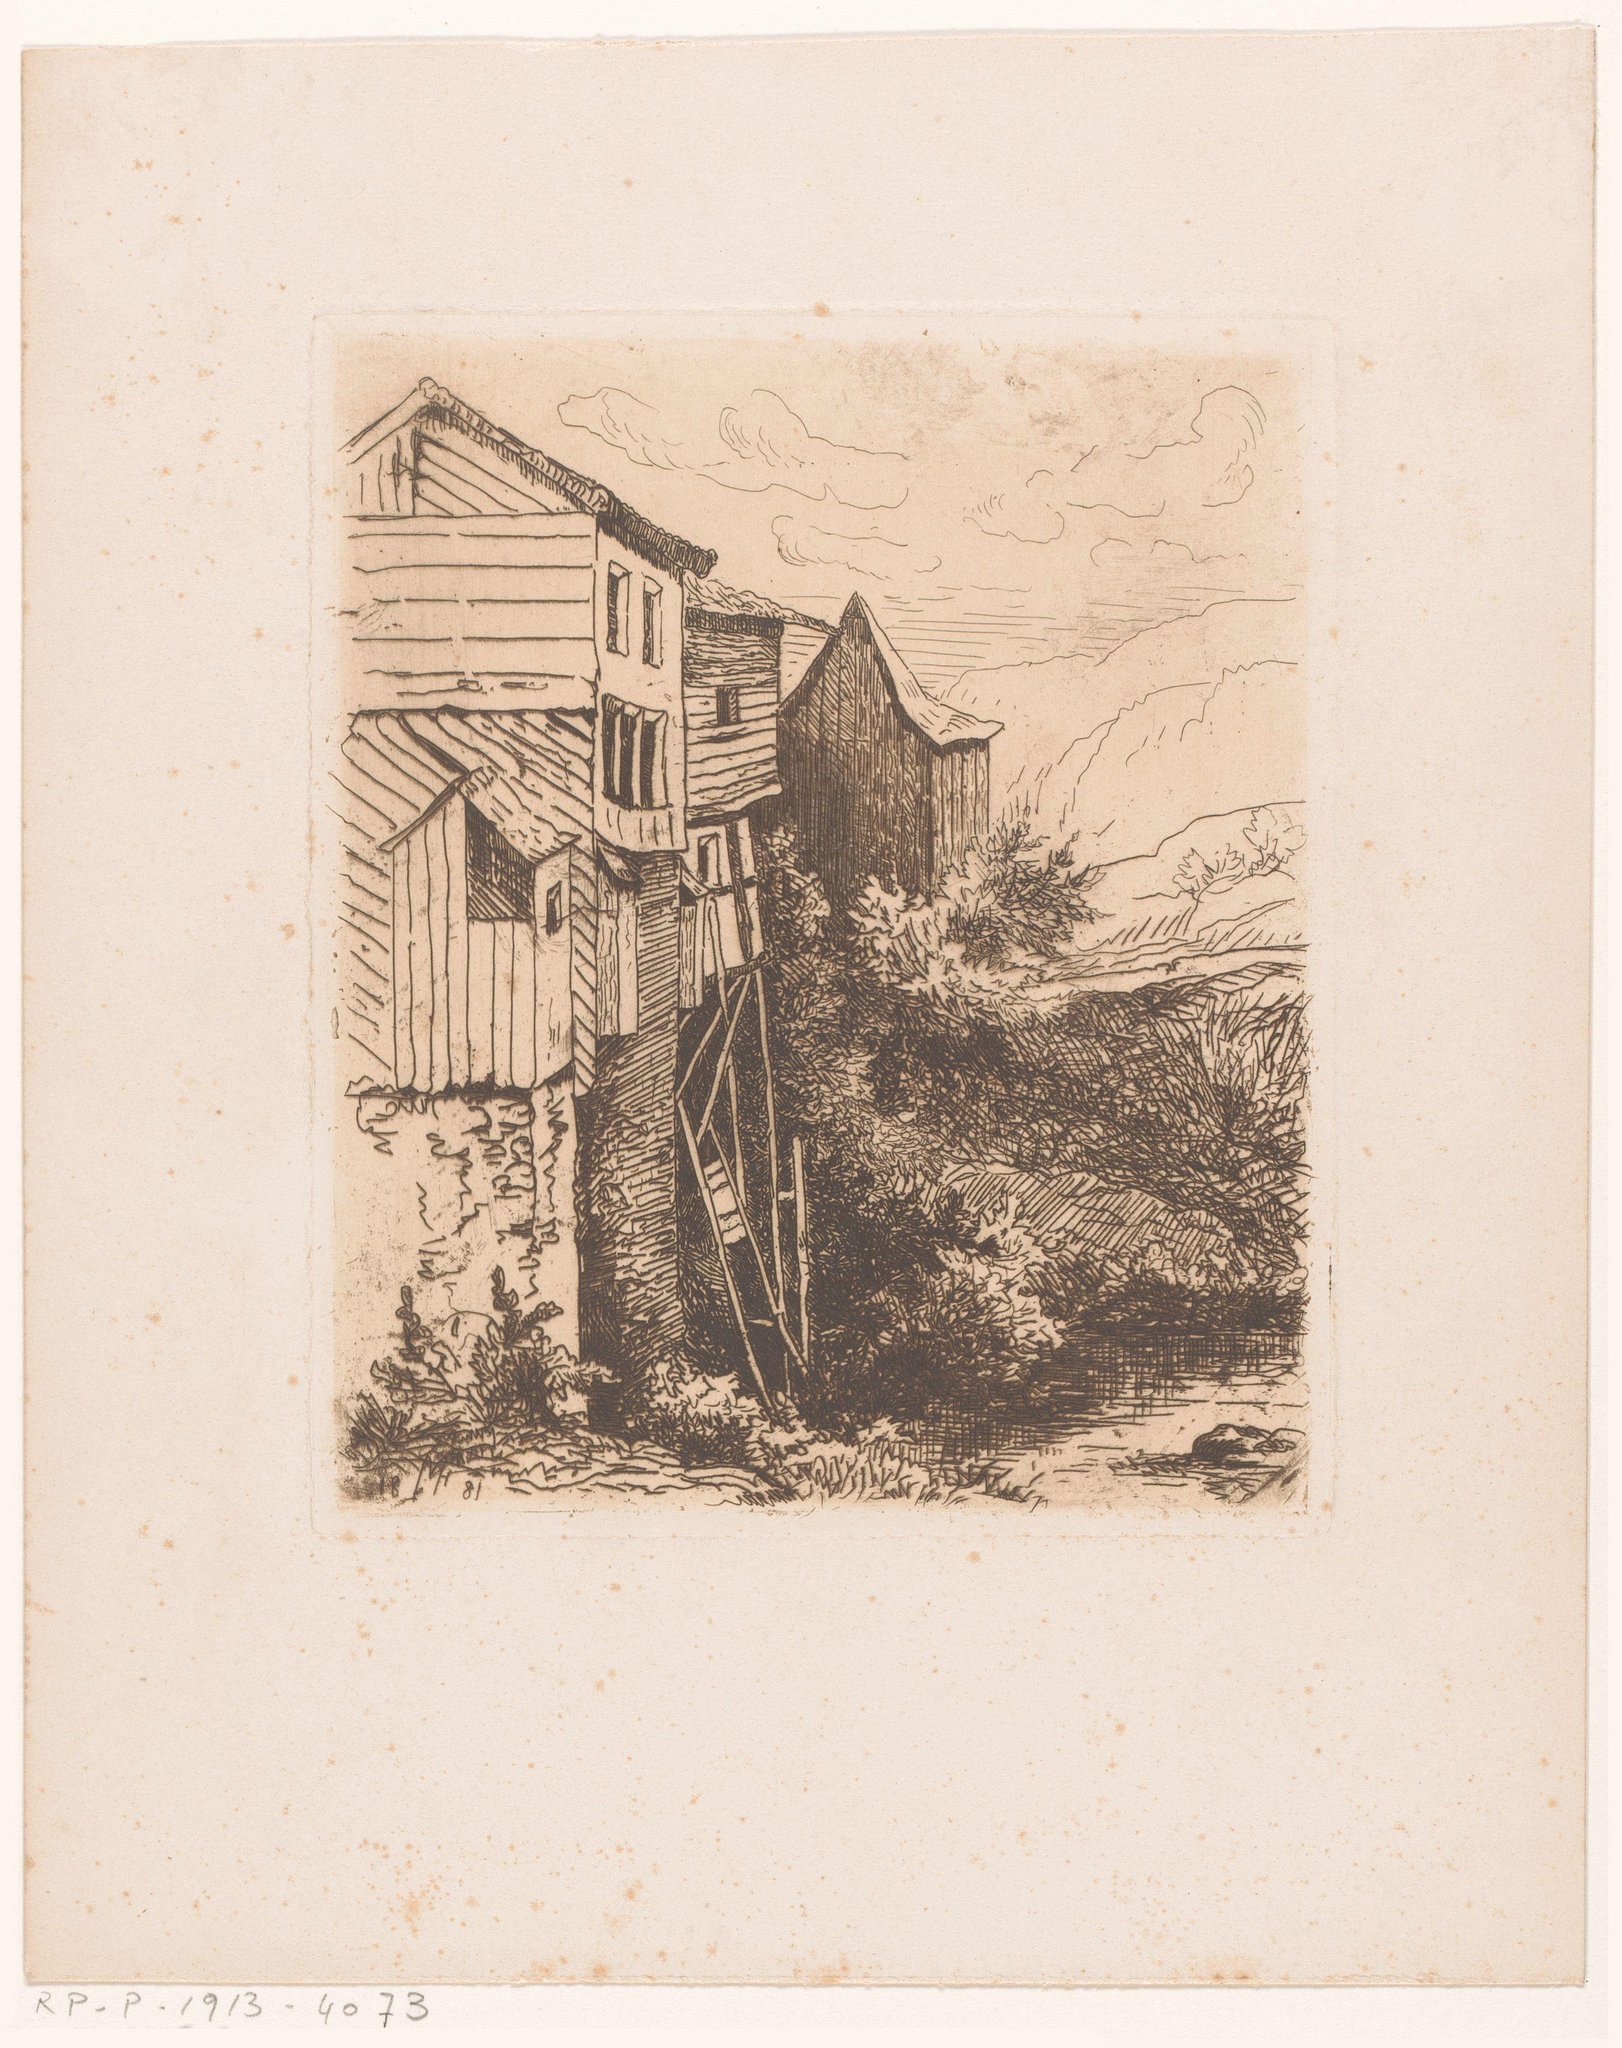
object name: print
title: Gezicht op een rij huizen in Tirol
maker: maria van hohenzollern-sigmaringen (gravin van vlaanderen)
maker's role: print maker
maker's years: 1845-1912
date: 1881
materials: paper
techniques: drypoint, etching, intaglio, retroussage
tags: village, mountains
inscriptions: collector's mark: Lugt 2228